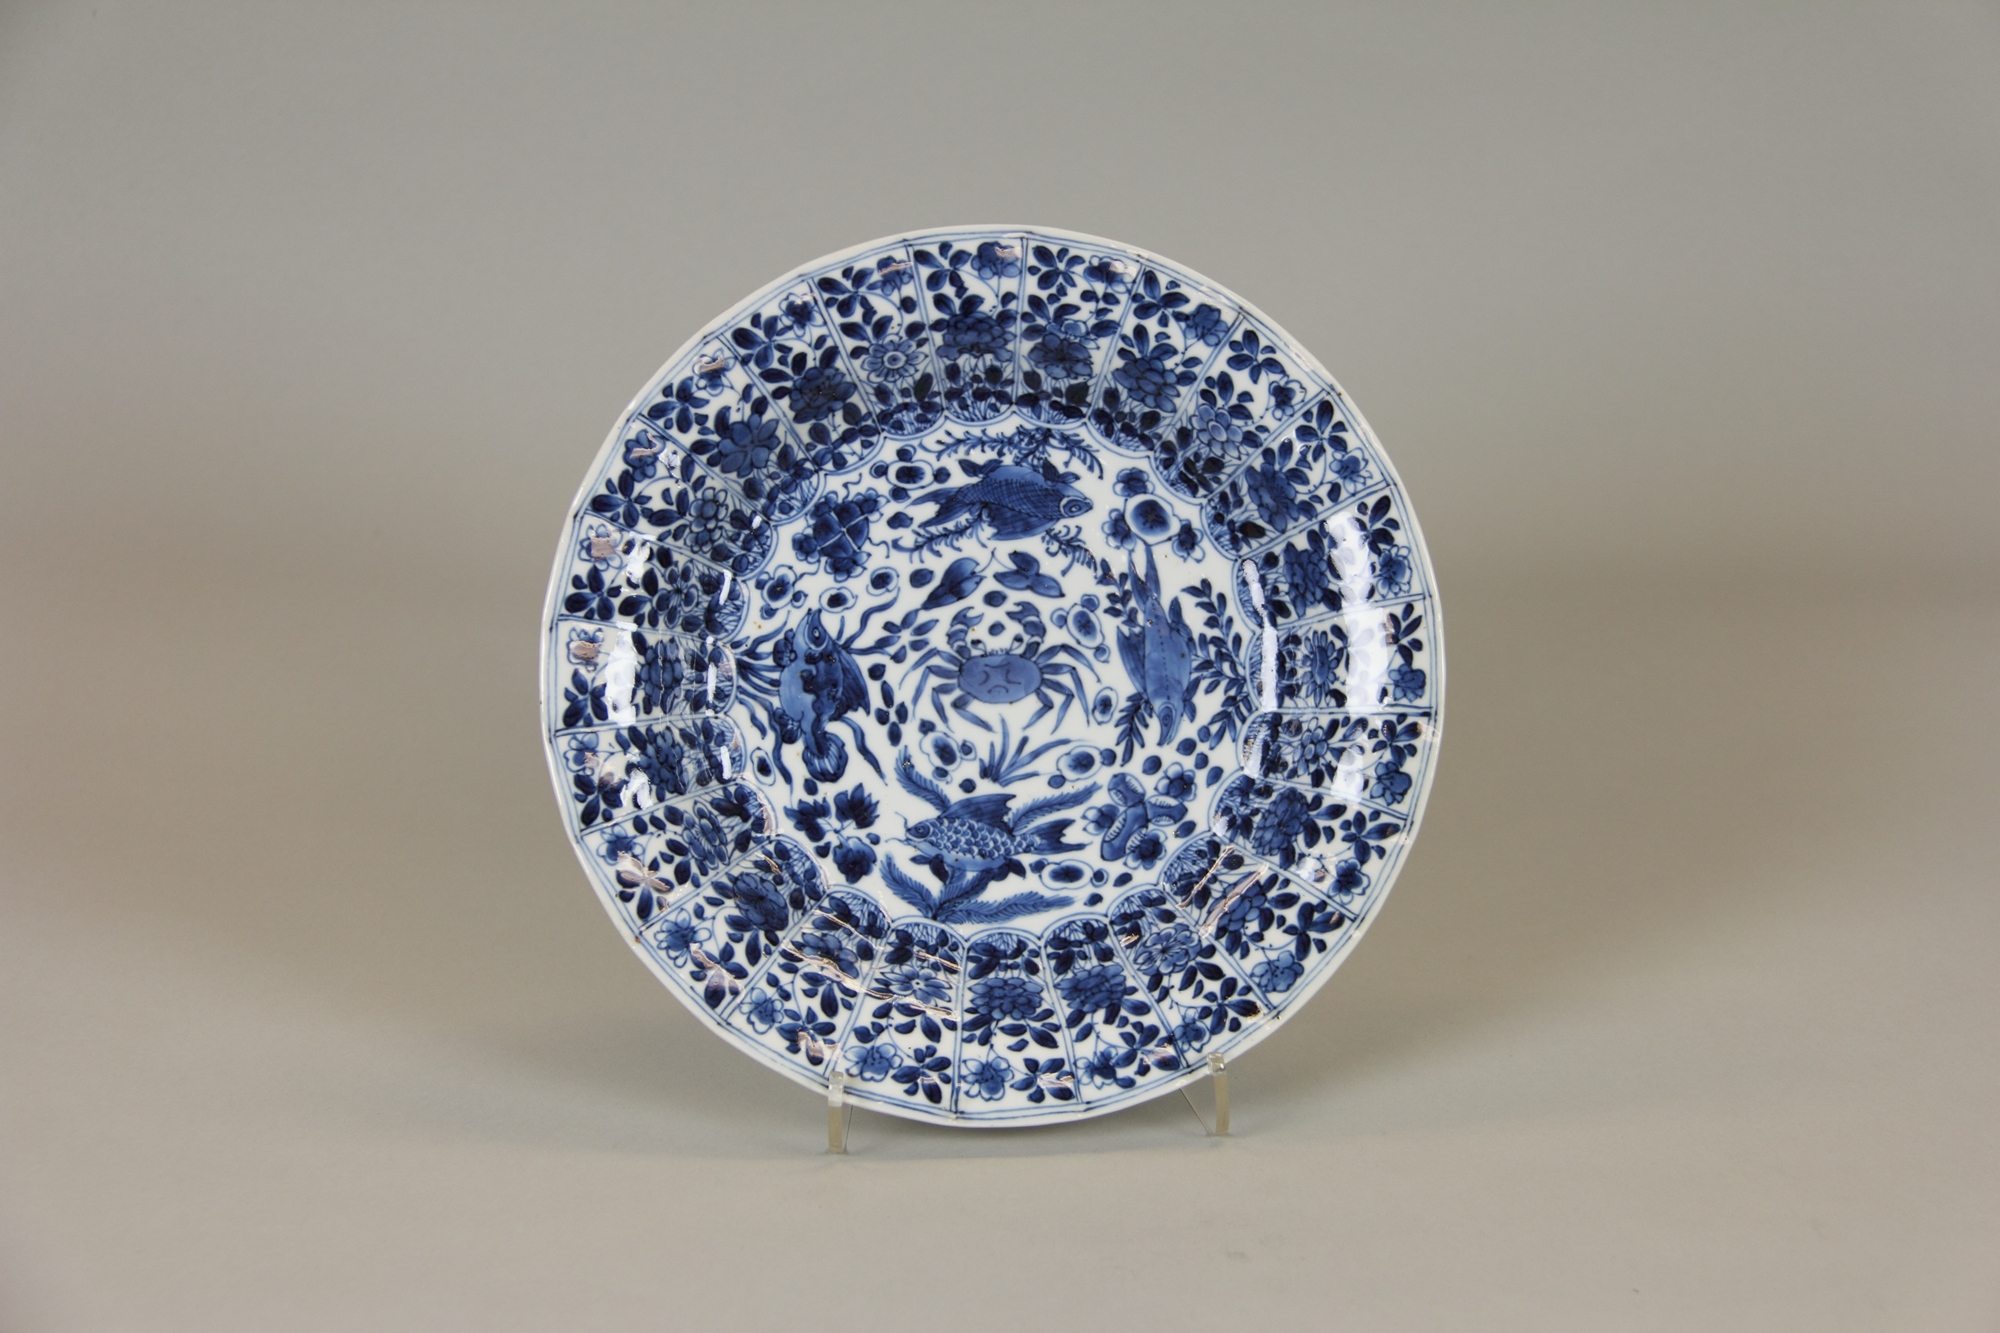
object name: plate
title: Plate with crab and fish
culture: chinese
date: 1667-1733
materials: cobalt, porcelain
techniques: painting, underglaze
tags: crabs,fish